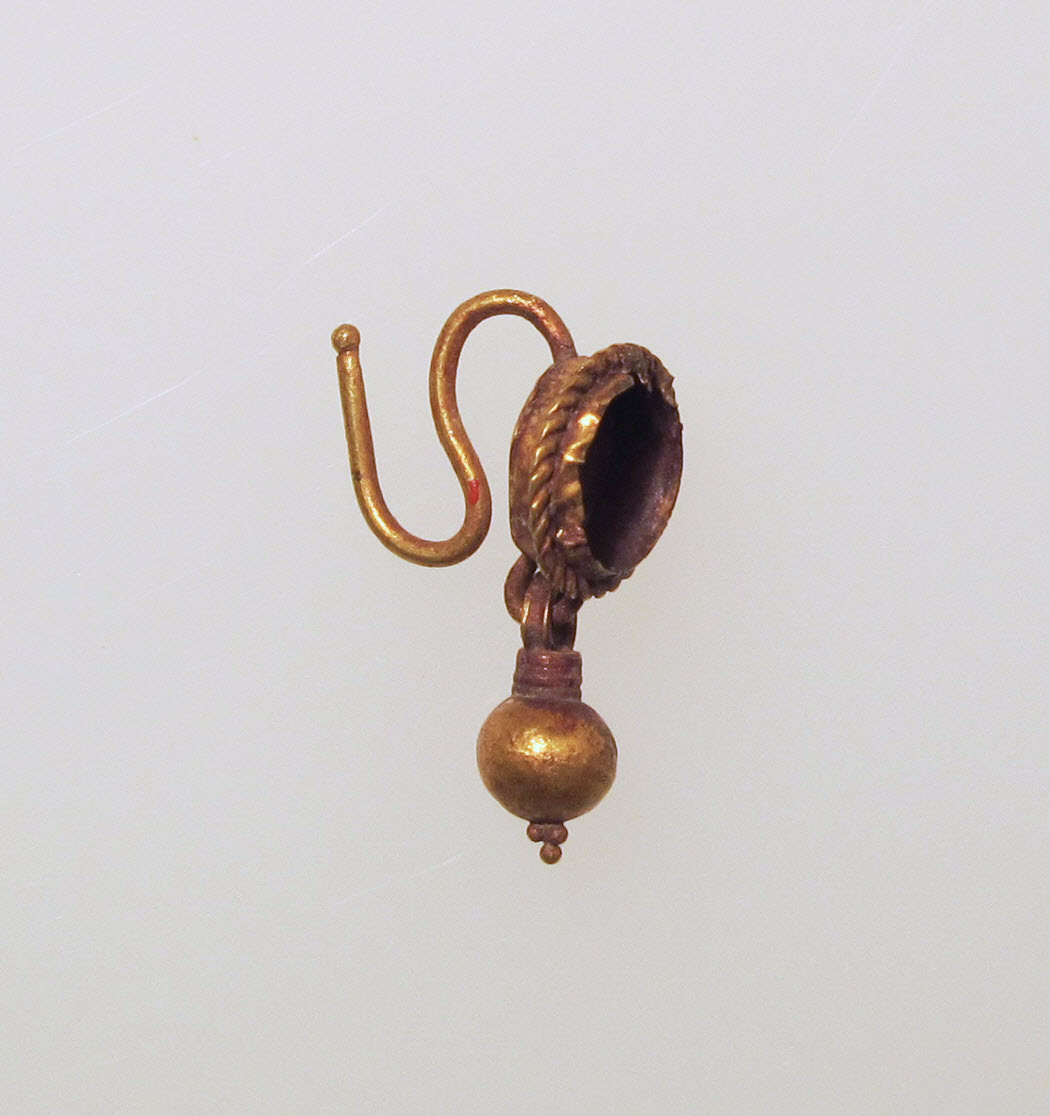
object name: earring hook type with pendant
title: Earring-hook type with pendant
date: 7000 BCE-330 CE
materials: gold